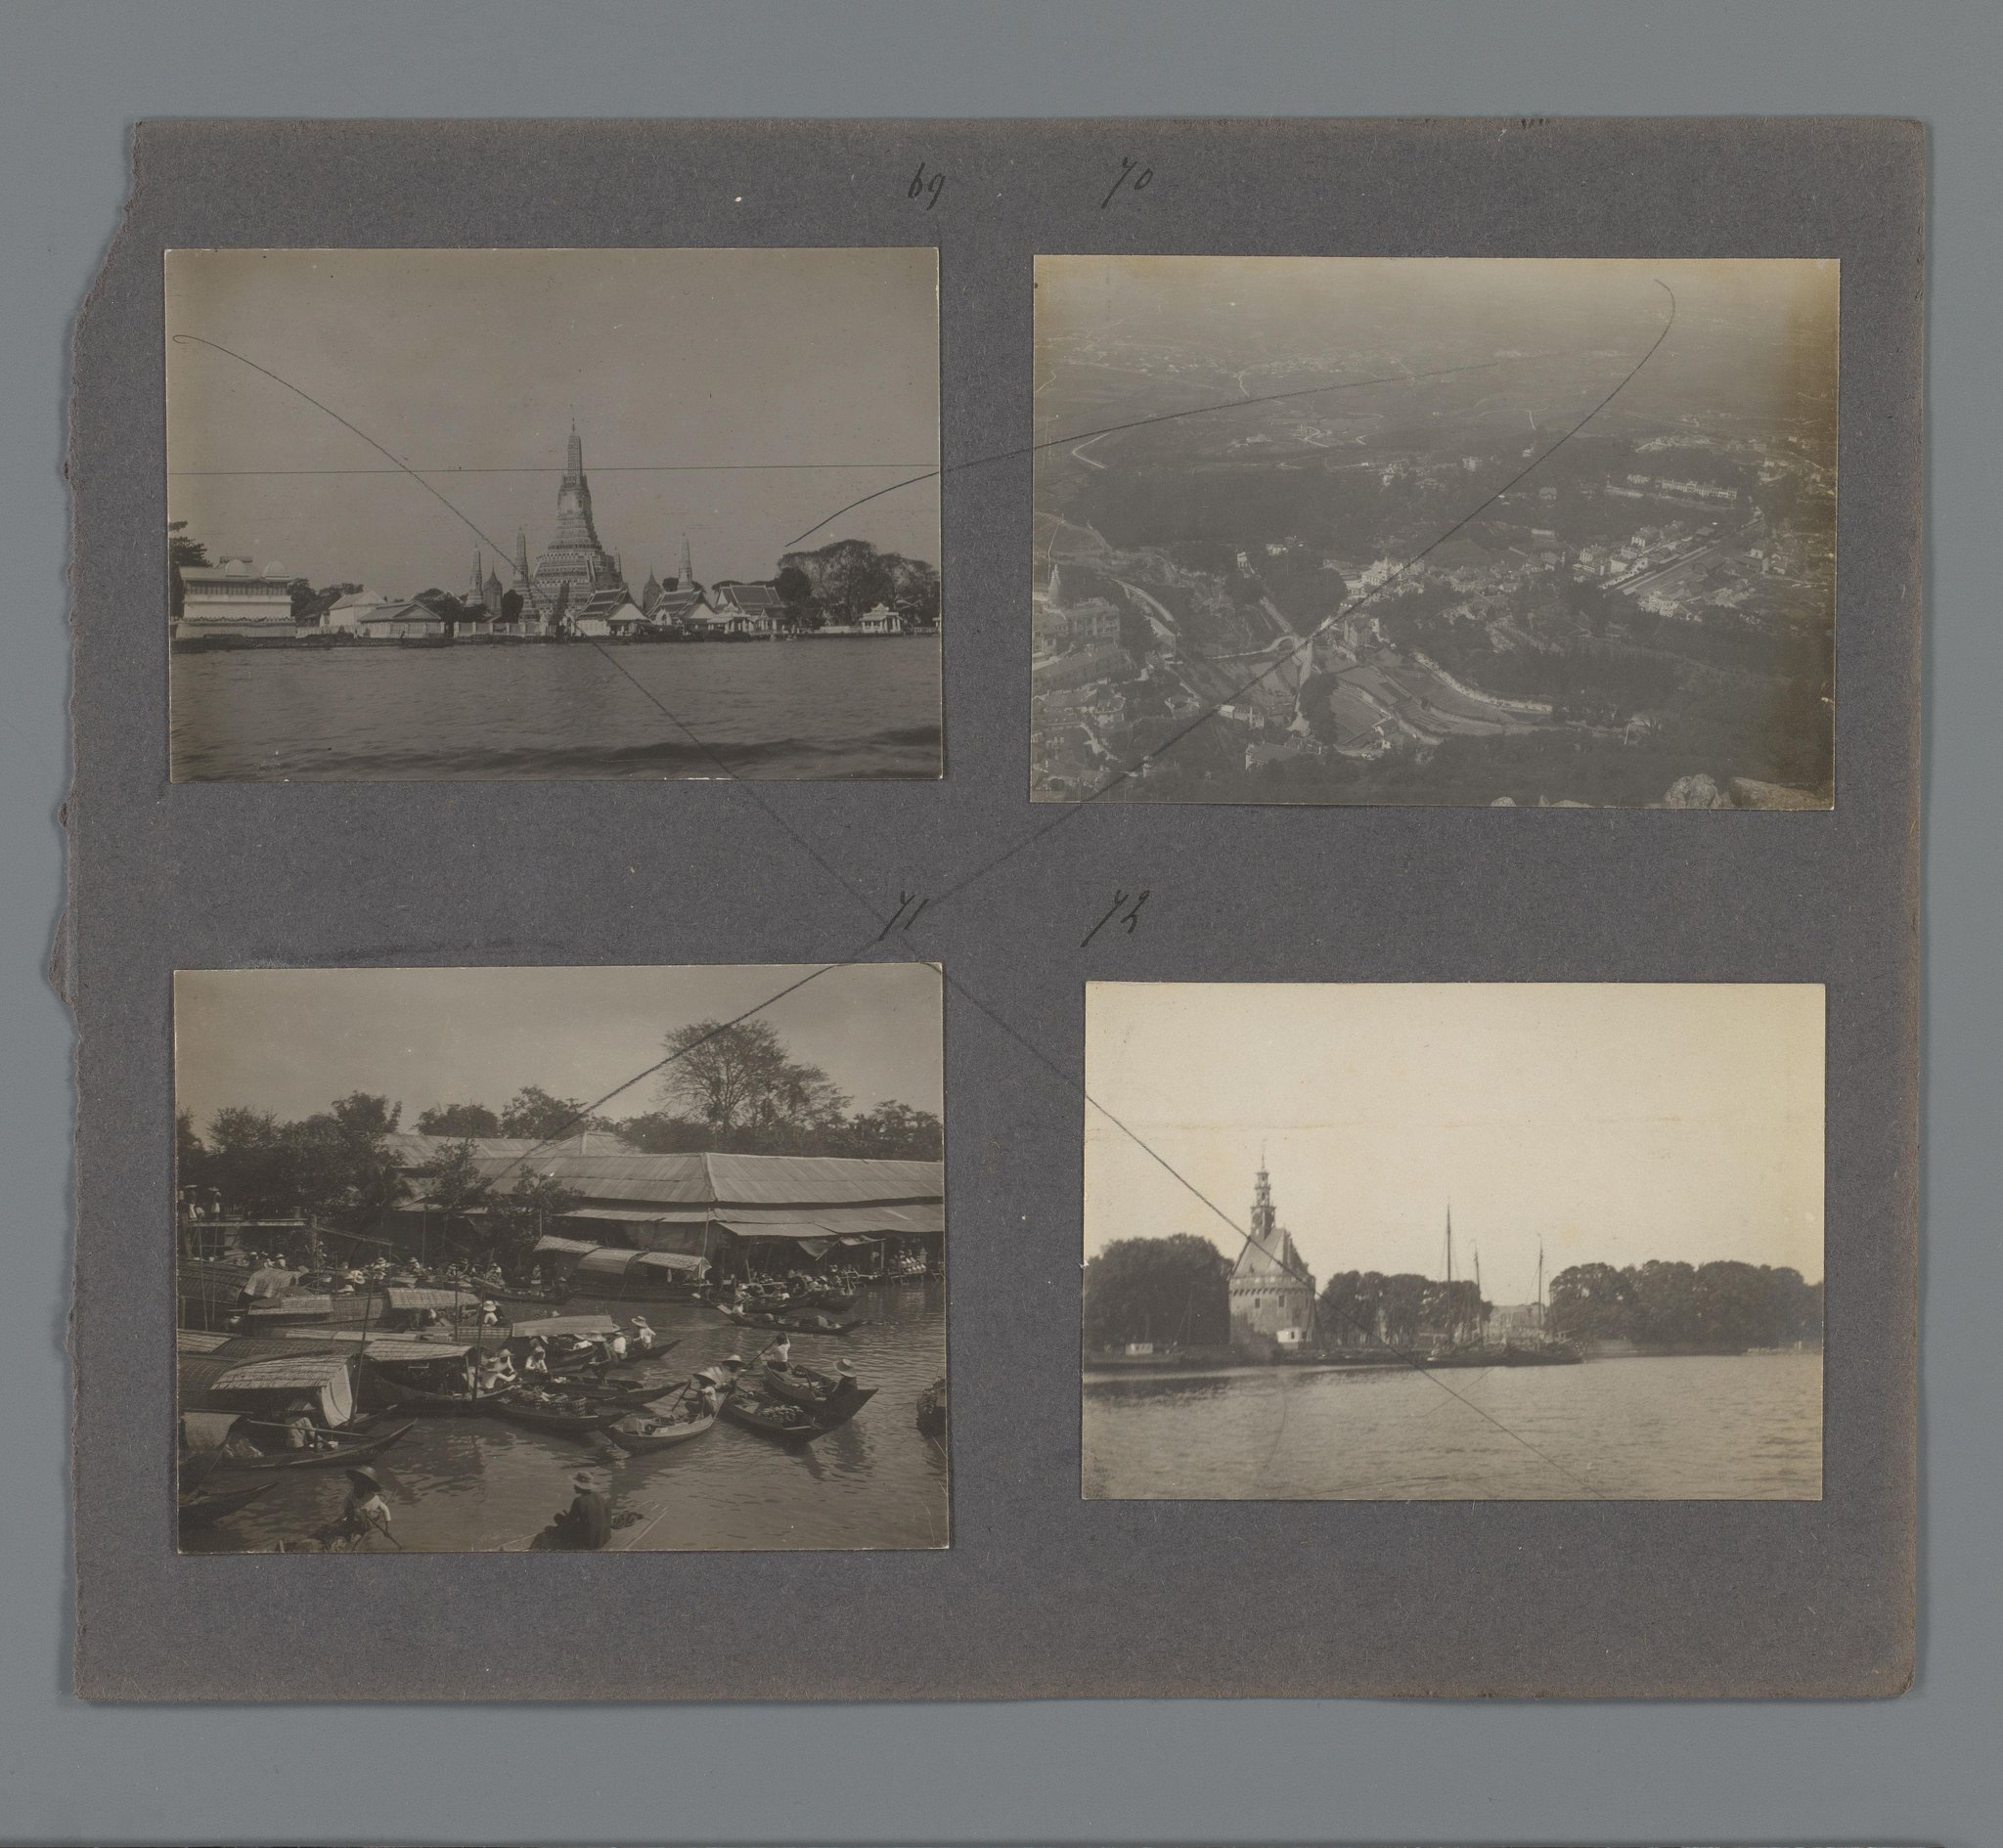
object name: photograph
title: Vier foto's met gezicht op dorpen of steden, één vanuit de lucht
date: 1895-1918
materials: paper, cardboard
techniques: gelatin silver print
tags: city-view in general; 'veduta', rowing-boat, canoe, etc.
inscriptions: number: ‘71’, number: ‘70’, number: ‘69’, number: ‘72’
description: Vermoedelijk albumblad uit album gescheurd.